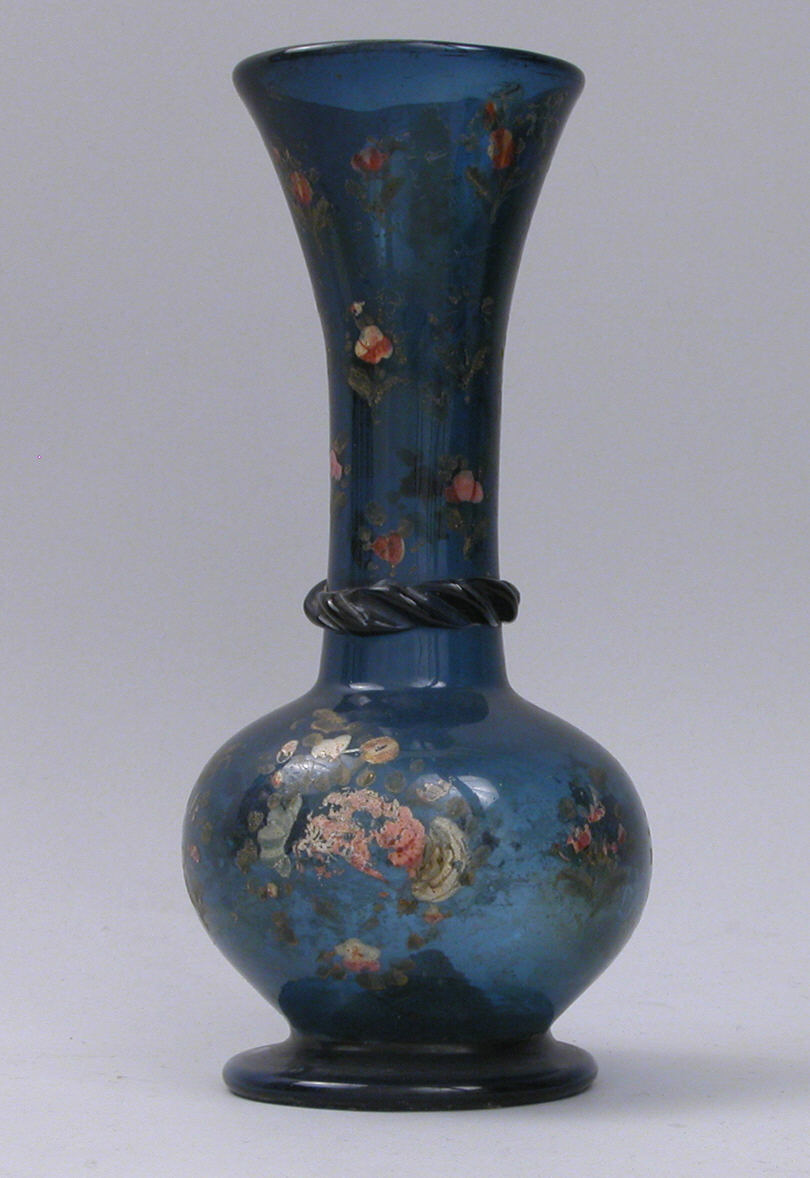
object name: vase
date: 1701-1900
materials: glass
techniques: glassblowing, painting, tooling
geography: iran